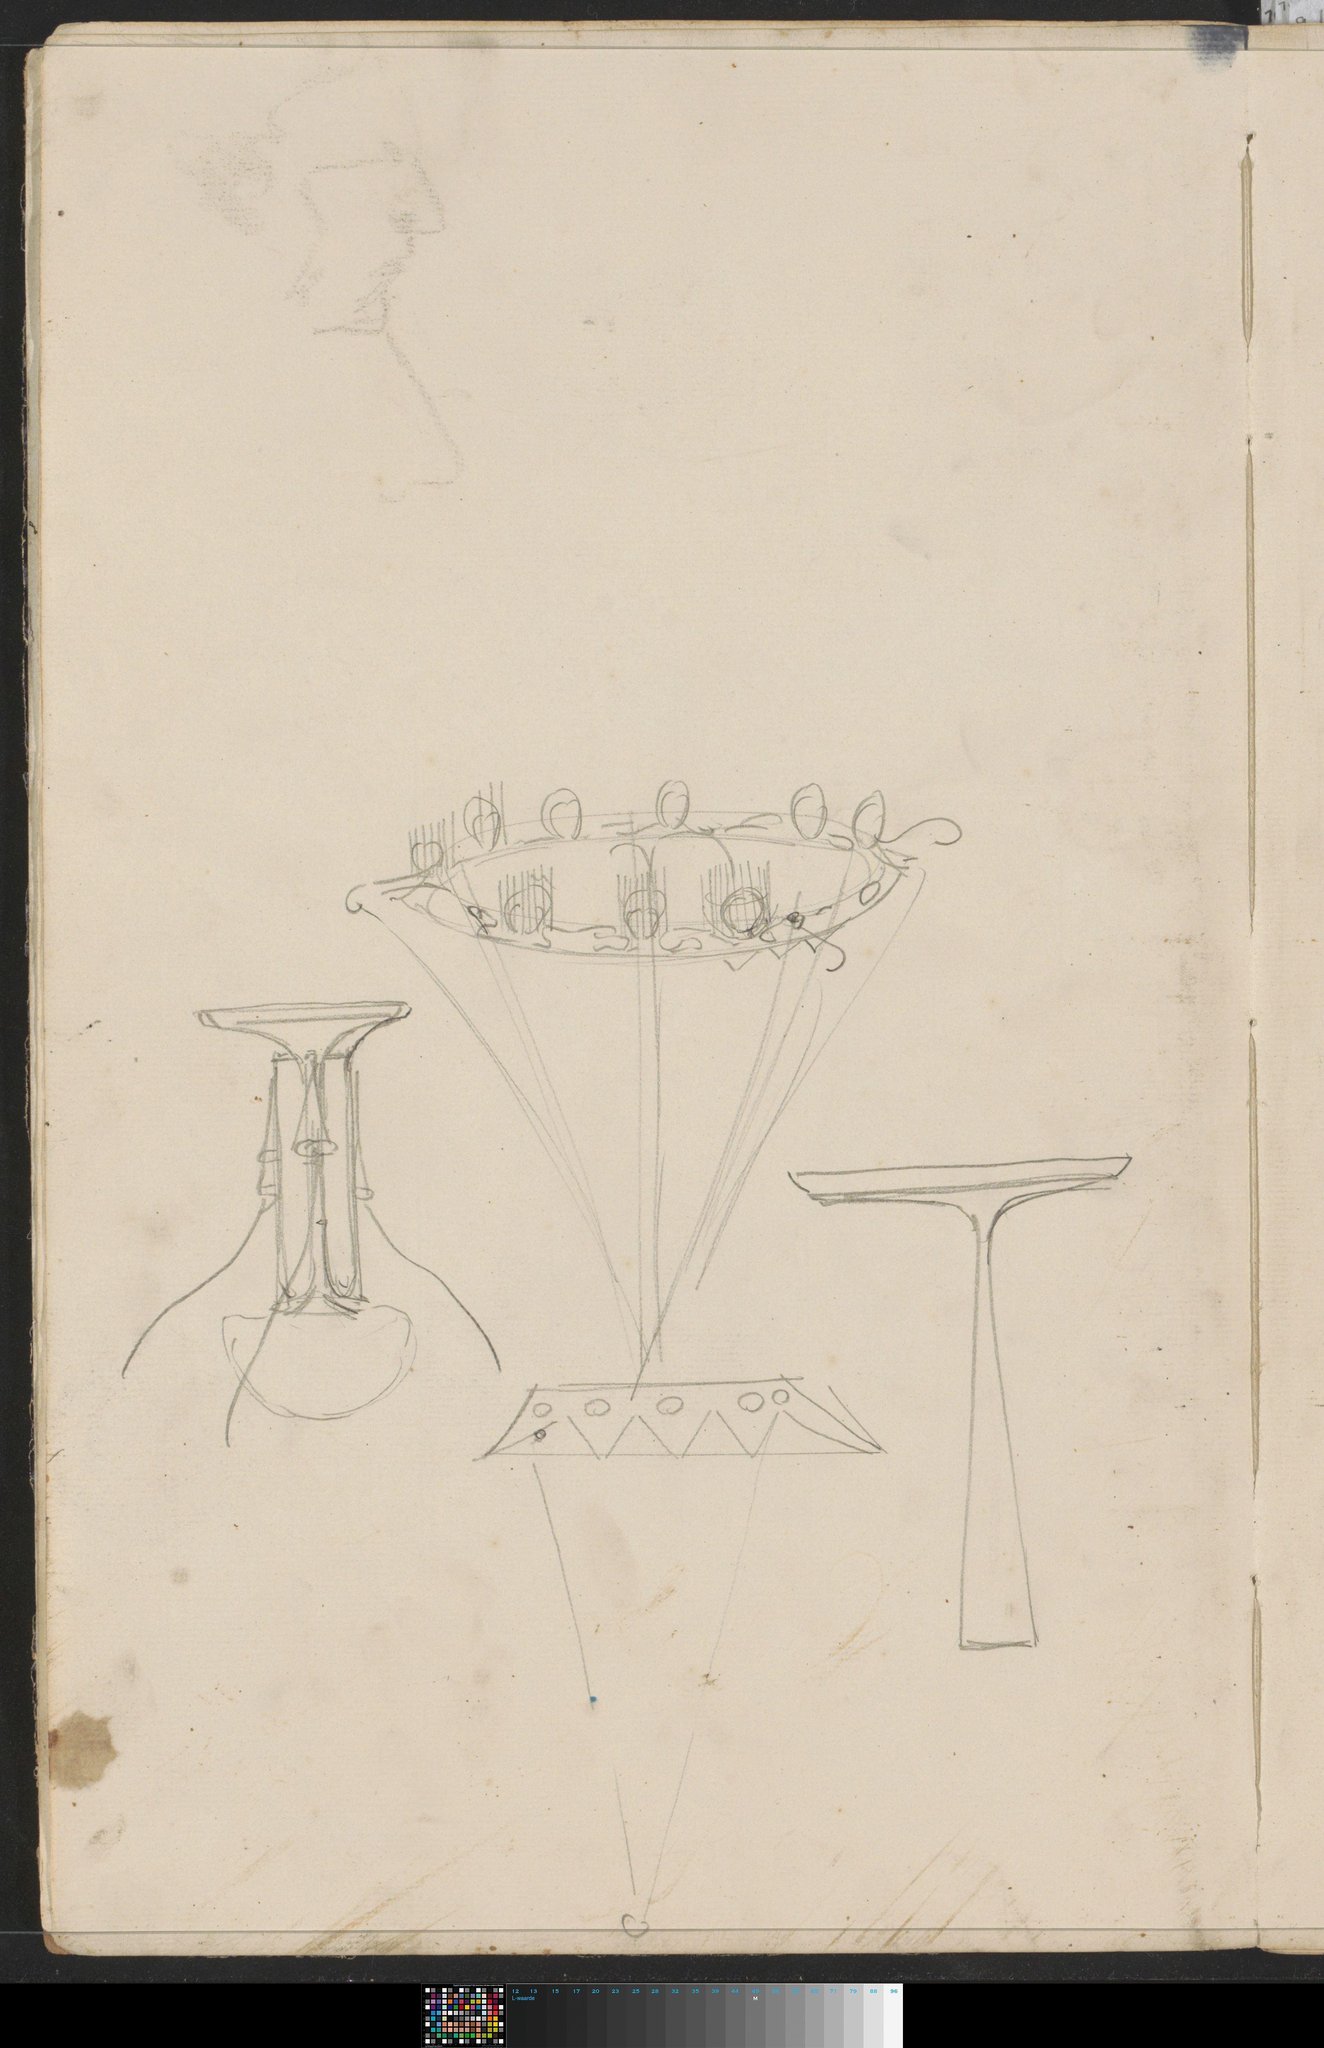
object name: sketchbook leaf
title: Lampen en een kroonluchter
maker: carel adolph lion cachet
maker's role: draughtsman, print maker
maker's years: 1864-1945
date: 1897-1898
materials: paper, pencil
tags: chandelier, candelabrum, lighting; lamps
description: Blad 4 verso uit een schetsboek met 29 bladen.